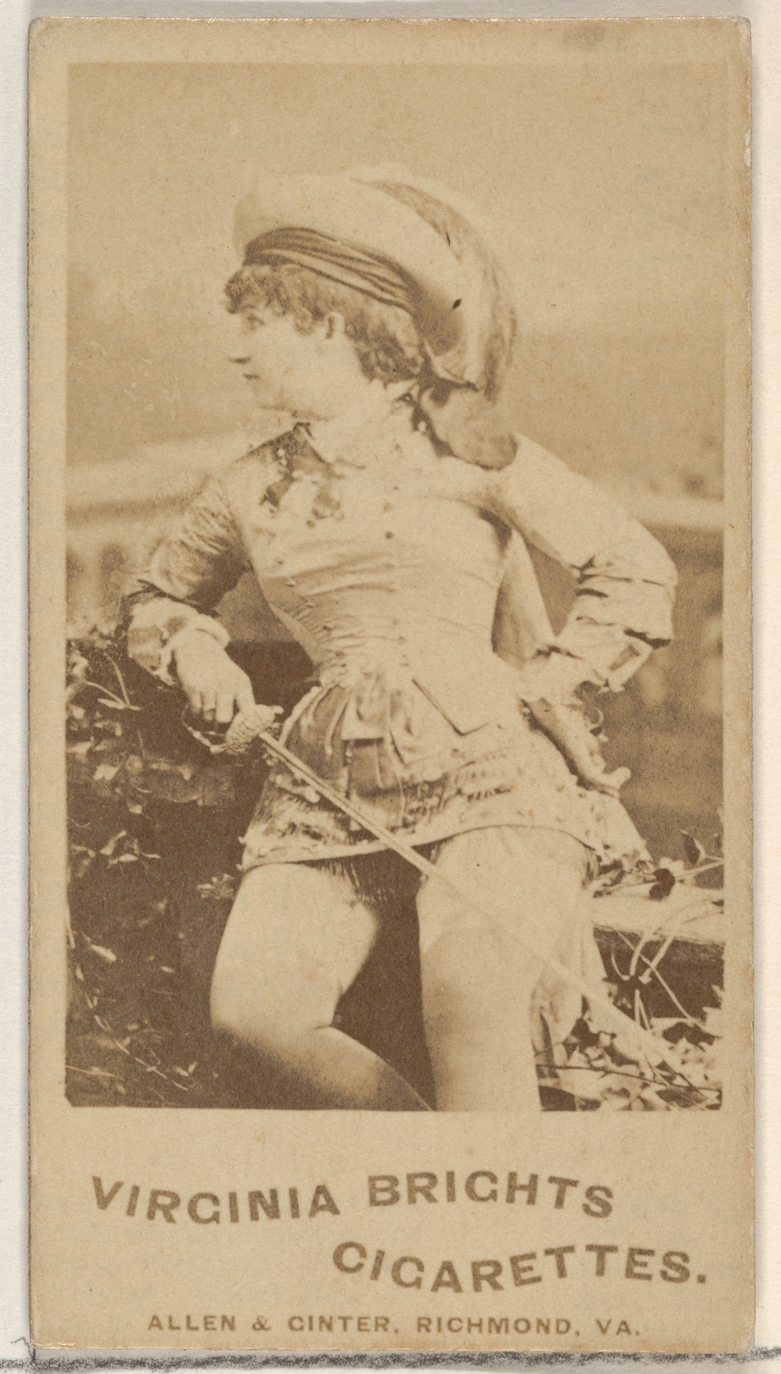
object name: photograph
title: From the Actors and Actresses series (N45, Type 5) for Virginia Brights Cigarettes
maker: allen & ginter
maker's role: publisher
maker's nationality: american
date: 1888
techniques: albumen silver print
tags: women,actresses